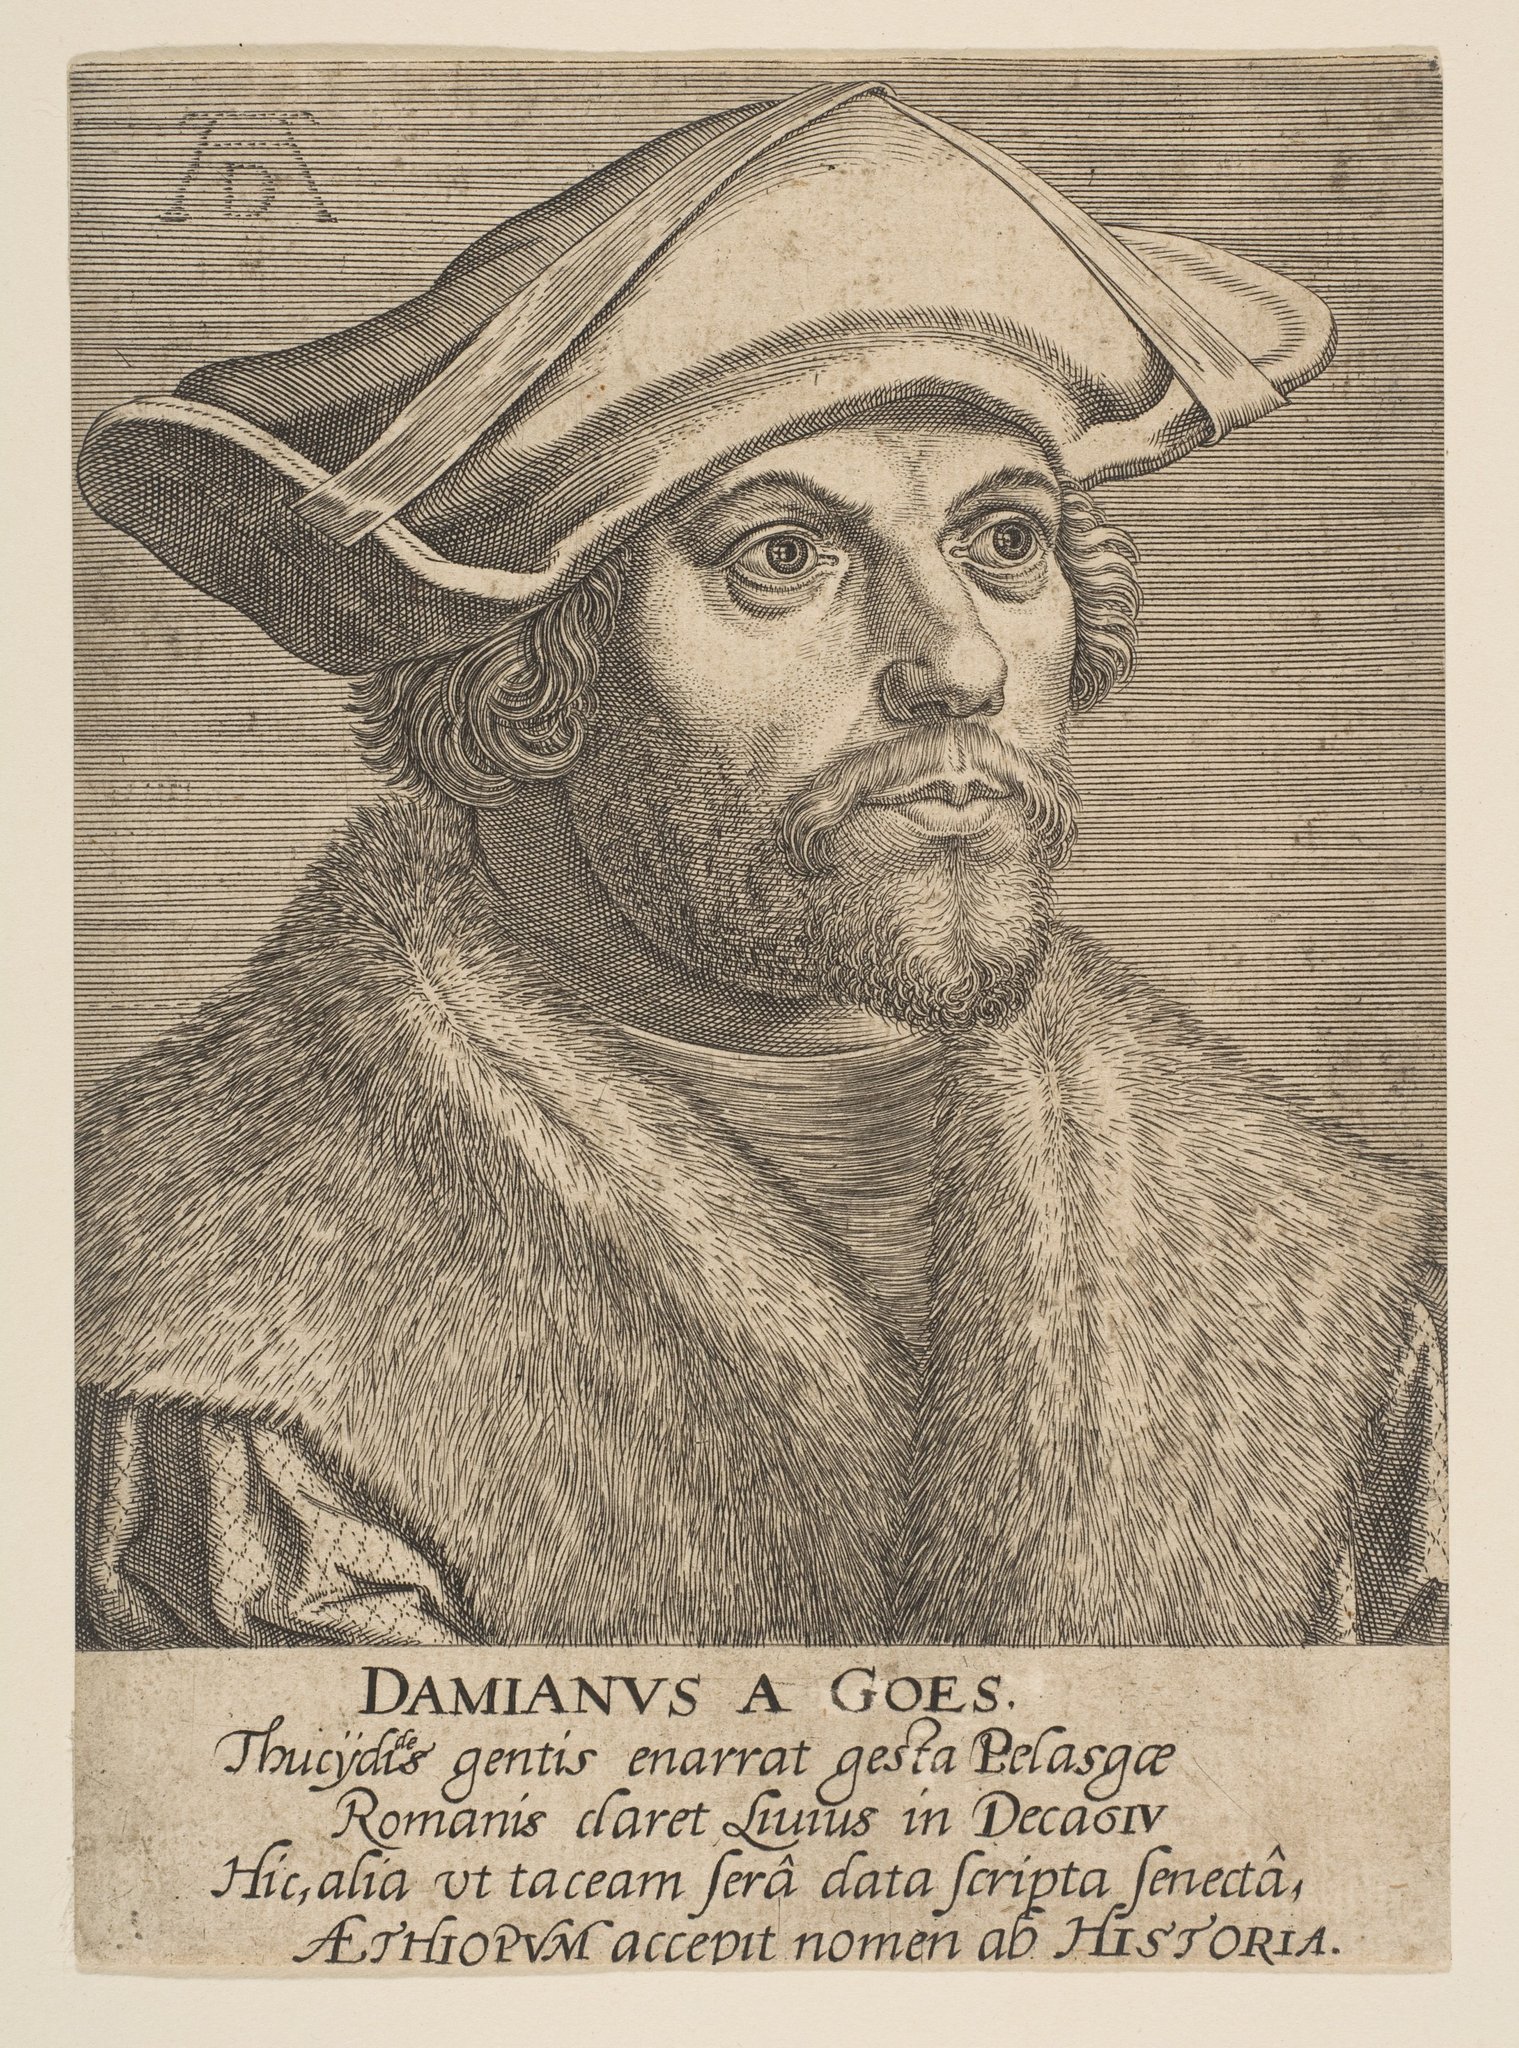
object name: print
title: Damaio de Gois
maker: philips galle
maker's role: artist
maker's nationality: netherlandish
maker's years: 1537-1612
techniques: engraving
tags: men,portraits